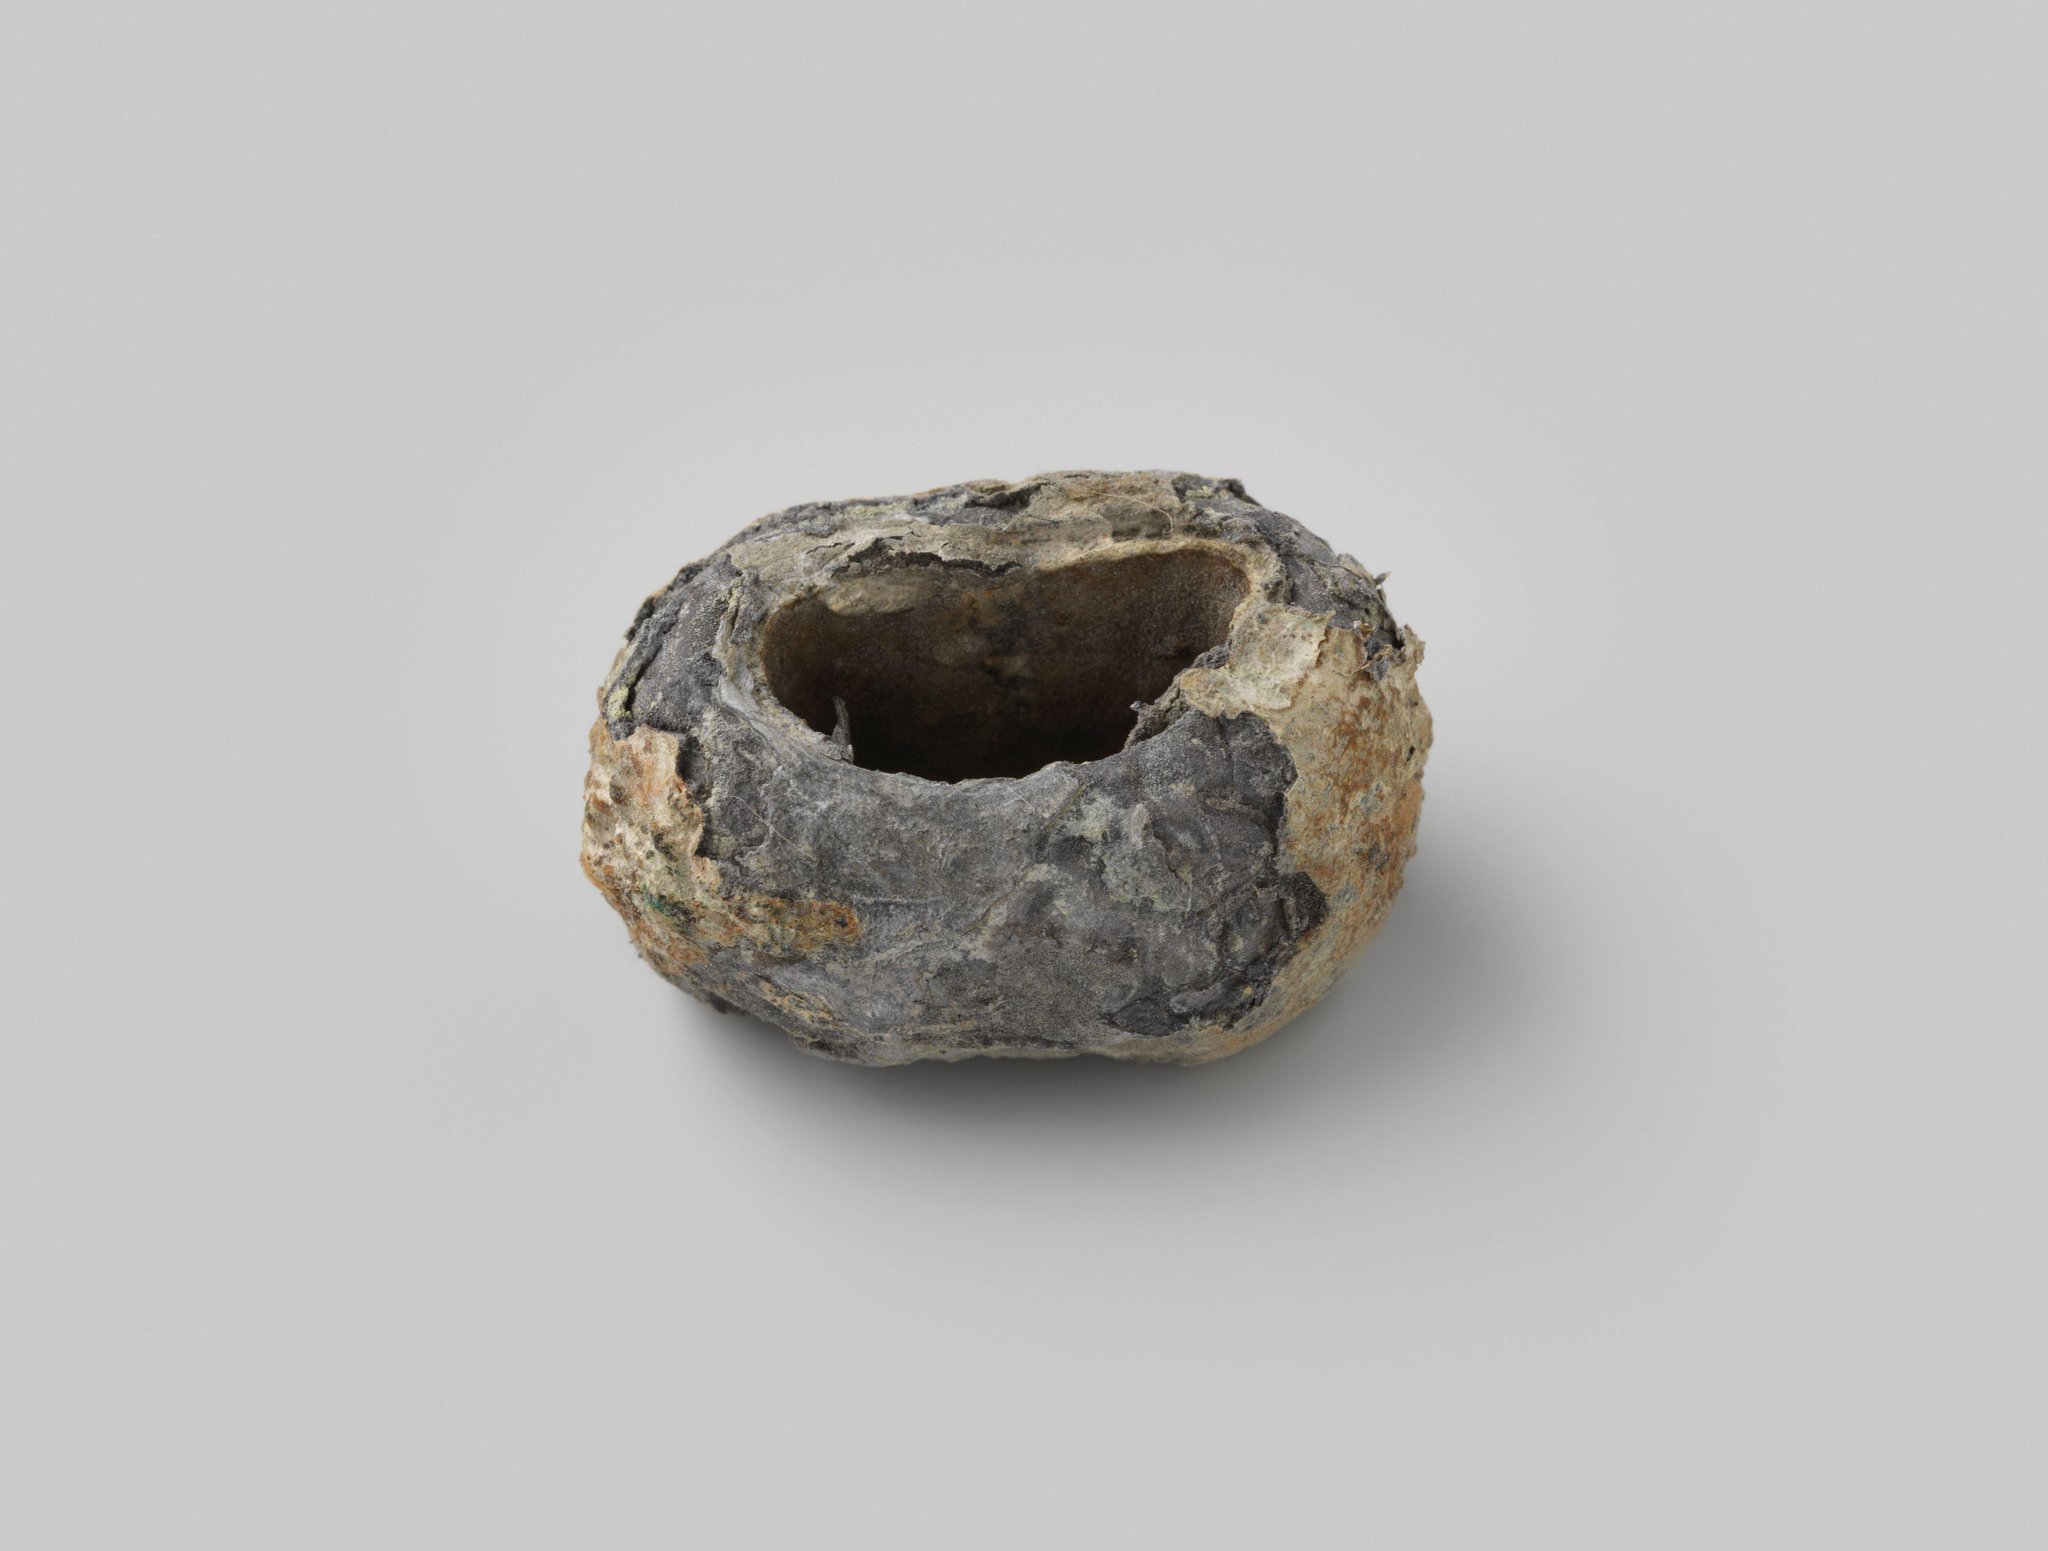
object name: ring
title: Vervormde, ringvormig fragment uit het wrak van de Oost-Indiëvaarder Hollandia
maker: Anonymous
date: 1700-1743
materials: lead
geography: netherlands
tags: verenigde oostindische compagnie, hollandia (schip), annet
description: Varied parts or fragments, rings and ring-shaped fragments; eroded, id. 80H787.